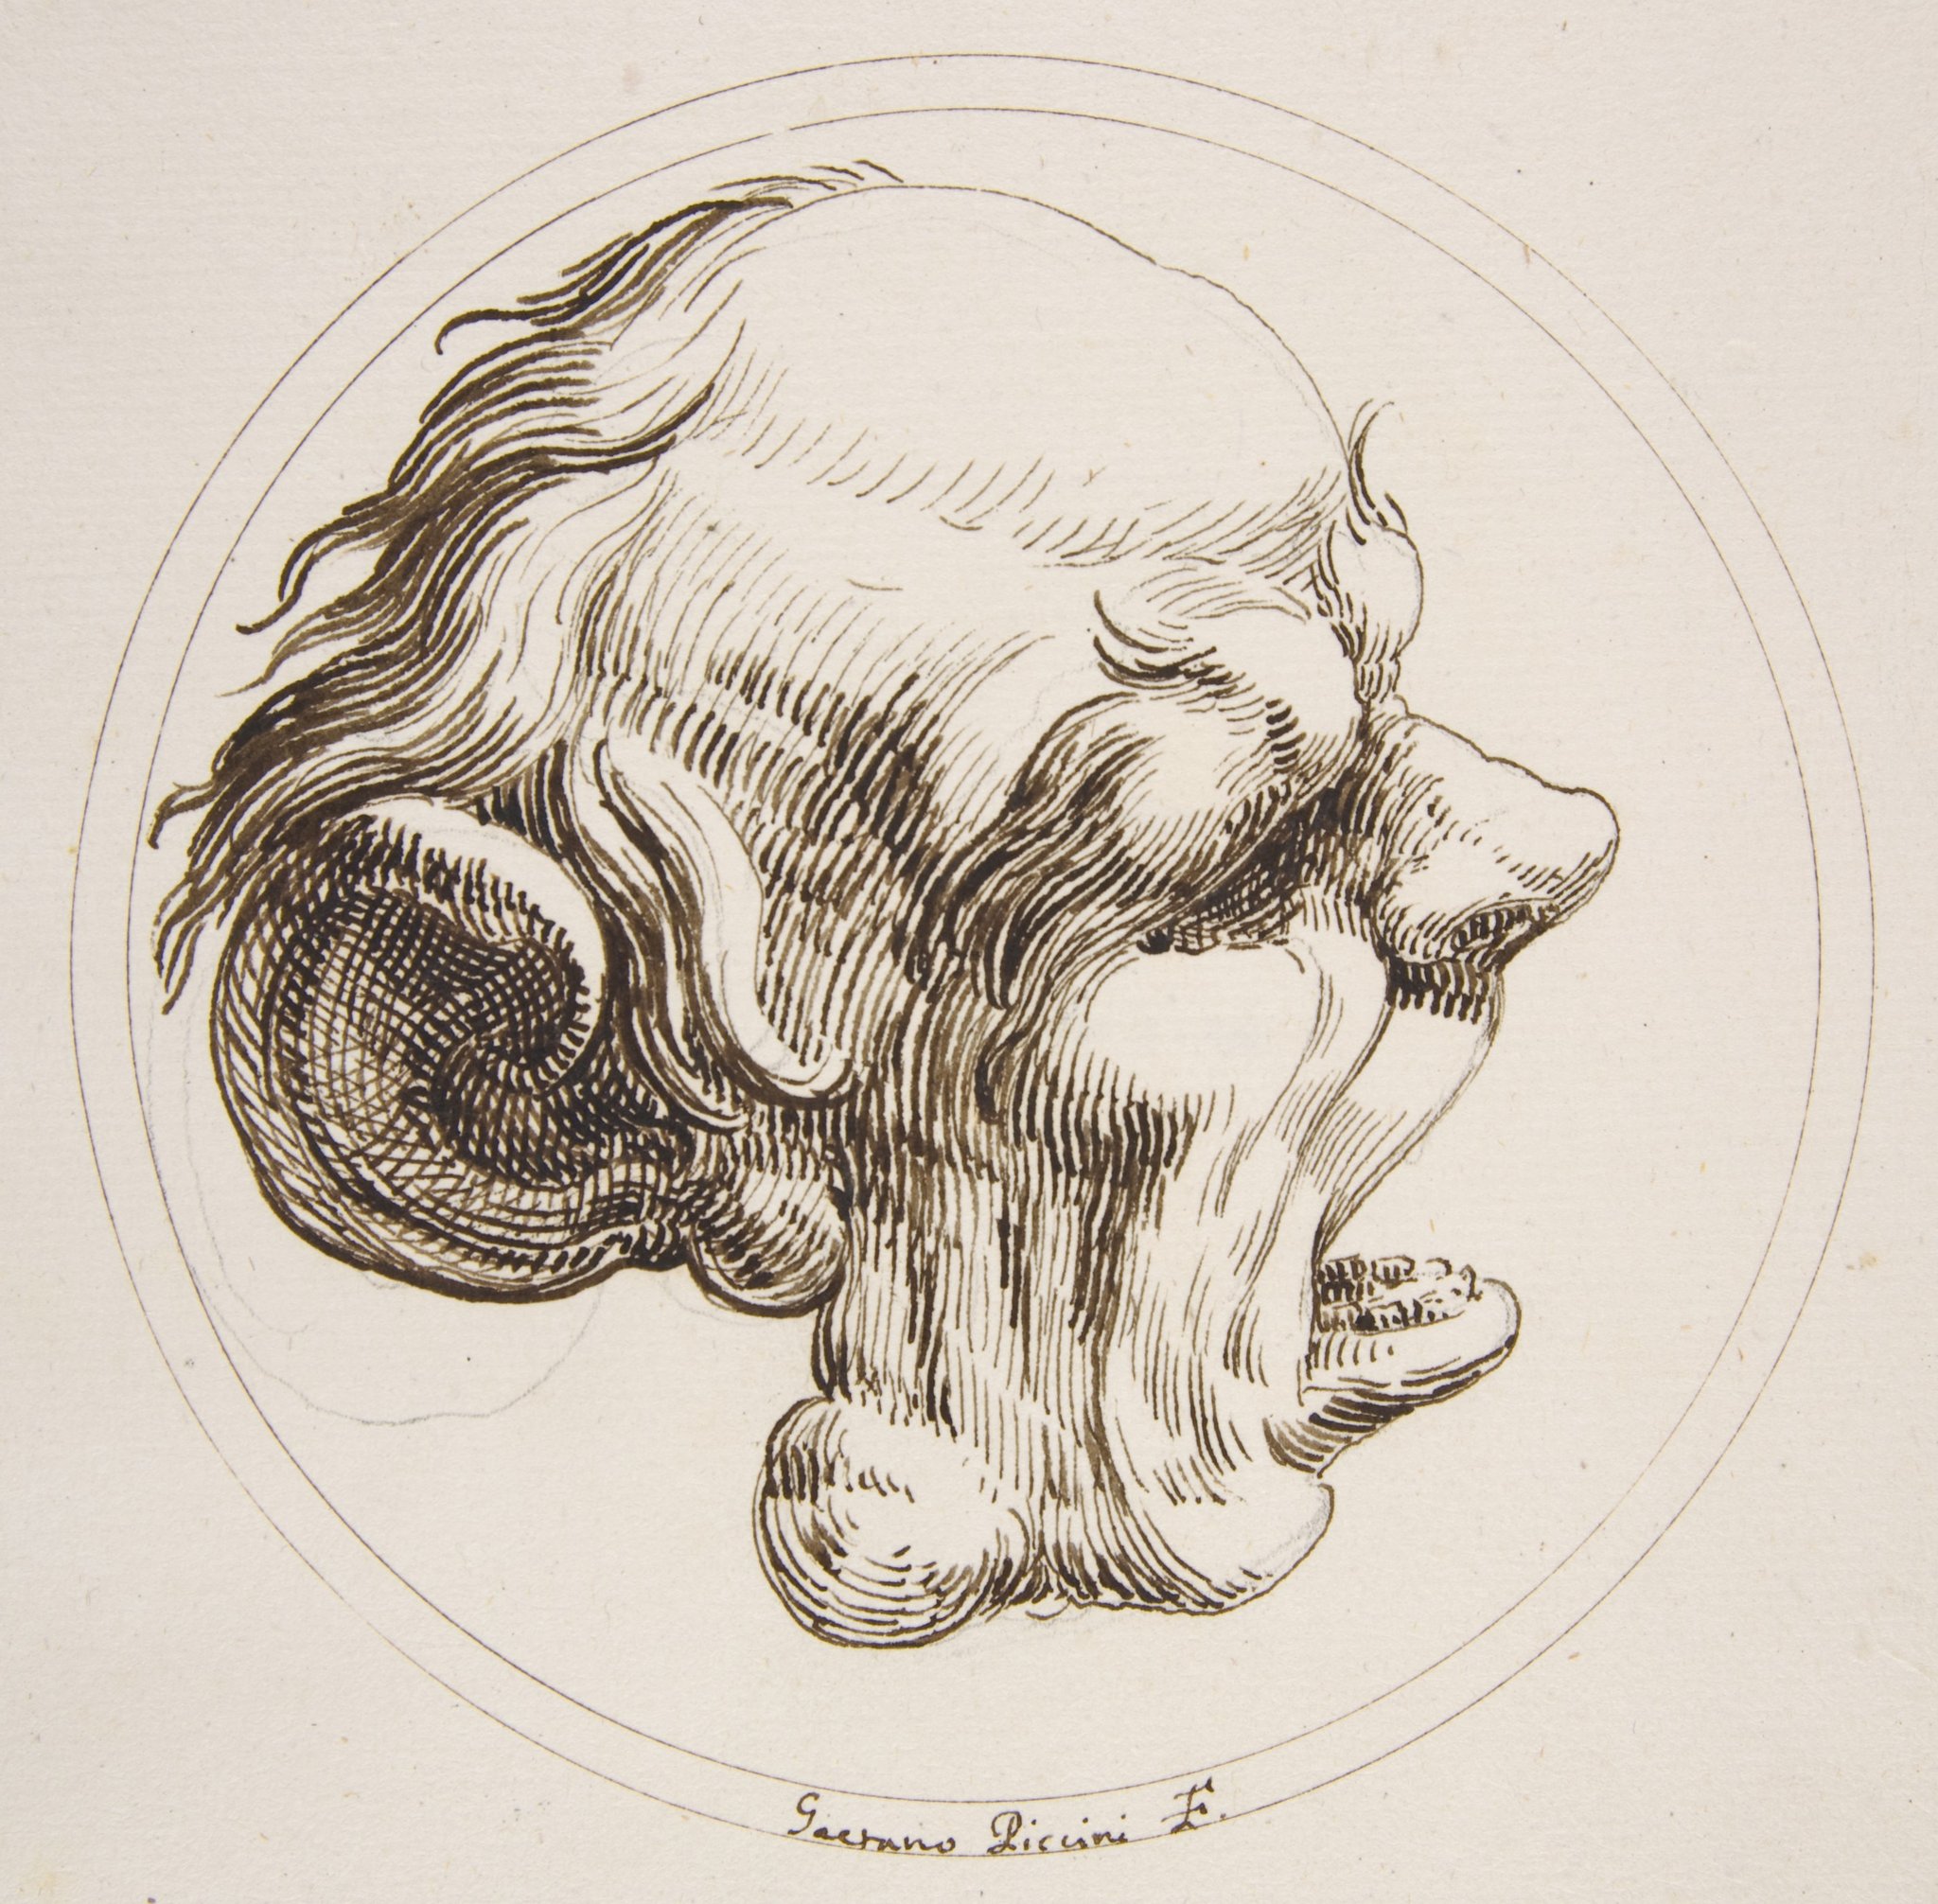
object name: drawing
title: Grotesque Head With a Large Ear and an Open Mouth Looking to the Right Within a Circle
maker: gaetano piccini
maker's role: artist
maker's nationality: italian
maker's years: 1710-1730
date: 1727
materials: ink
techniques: pen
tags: heads,men